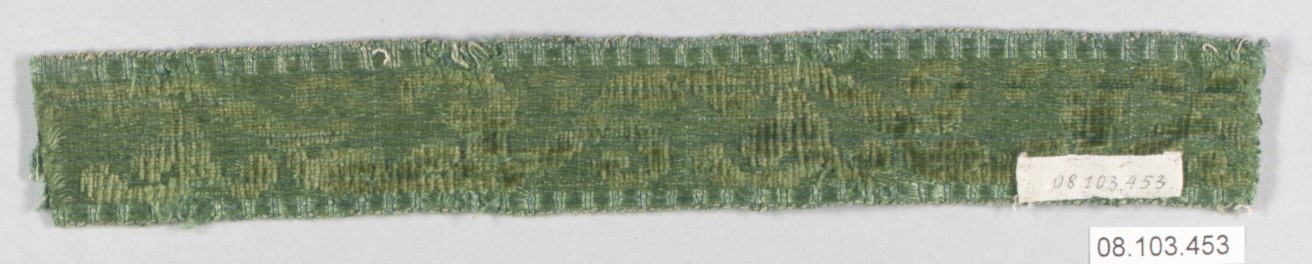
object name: galloon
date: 1801-1833